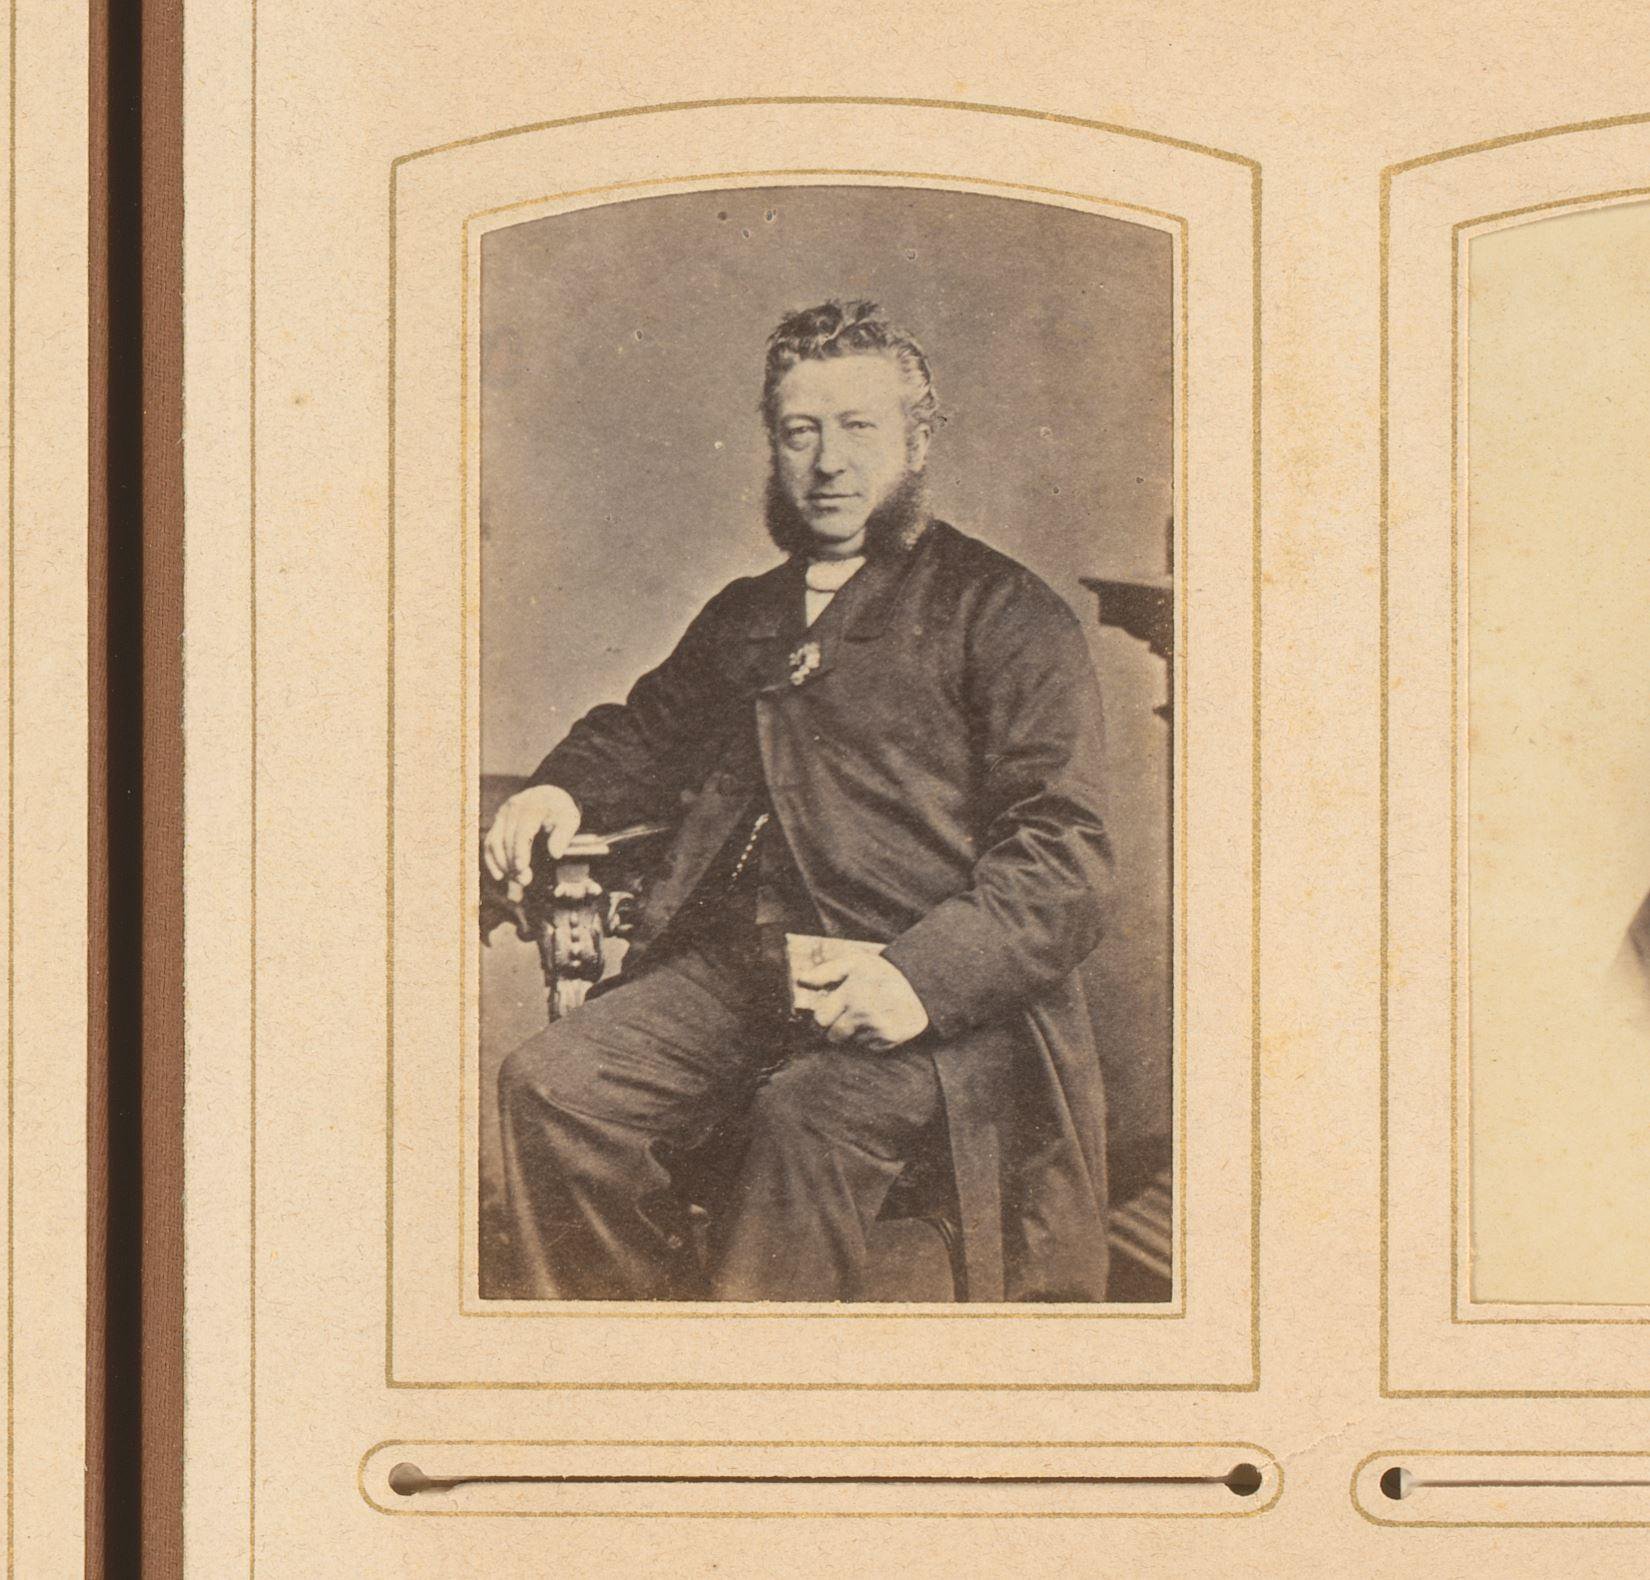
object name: album leaf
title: Portret van een zittende man met bakkebaarden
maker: Anonymous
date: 1860-1900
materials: cardboard, photographic support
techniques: albumen print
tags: sideburns, sitting figure, historical persons